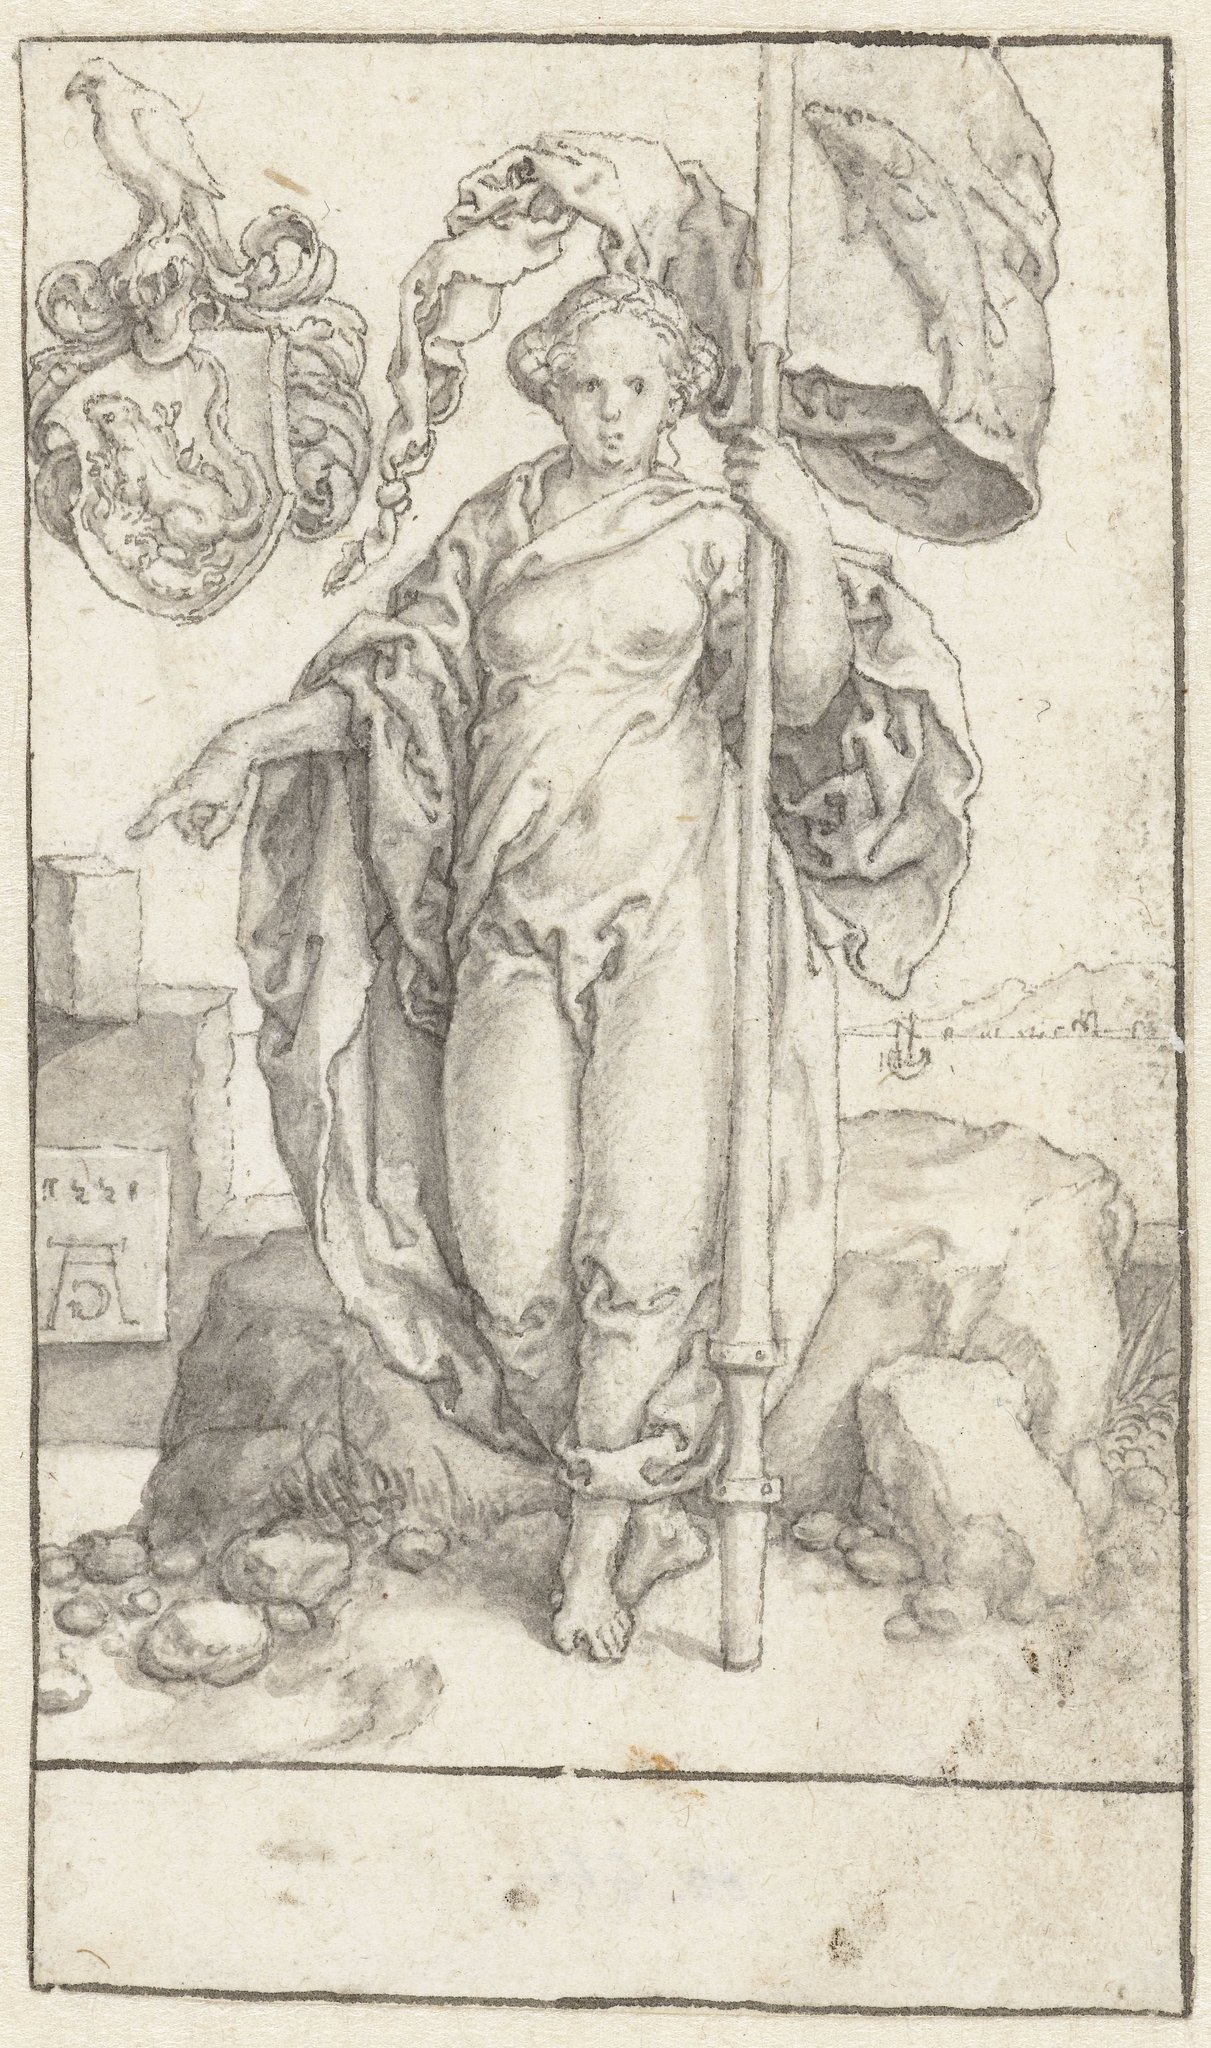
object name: design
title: Gematigdheid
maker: heinrich aldegrever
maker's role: draughtsman, print maker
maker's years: 1502-1561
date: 1551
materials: ink, paper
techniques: brush, pen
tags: temperance, 'temperantia'; 'temperanza' (ripa) ~ one of the four cardinal virtues